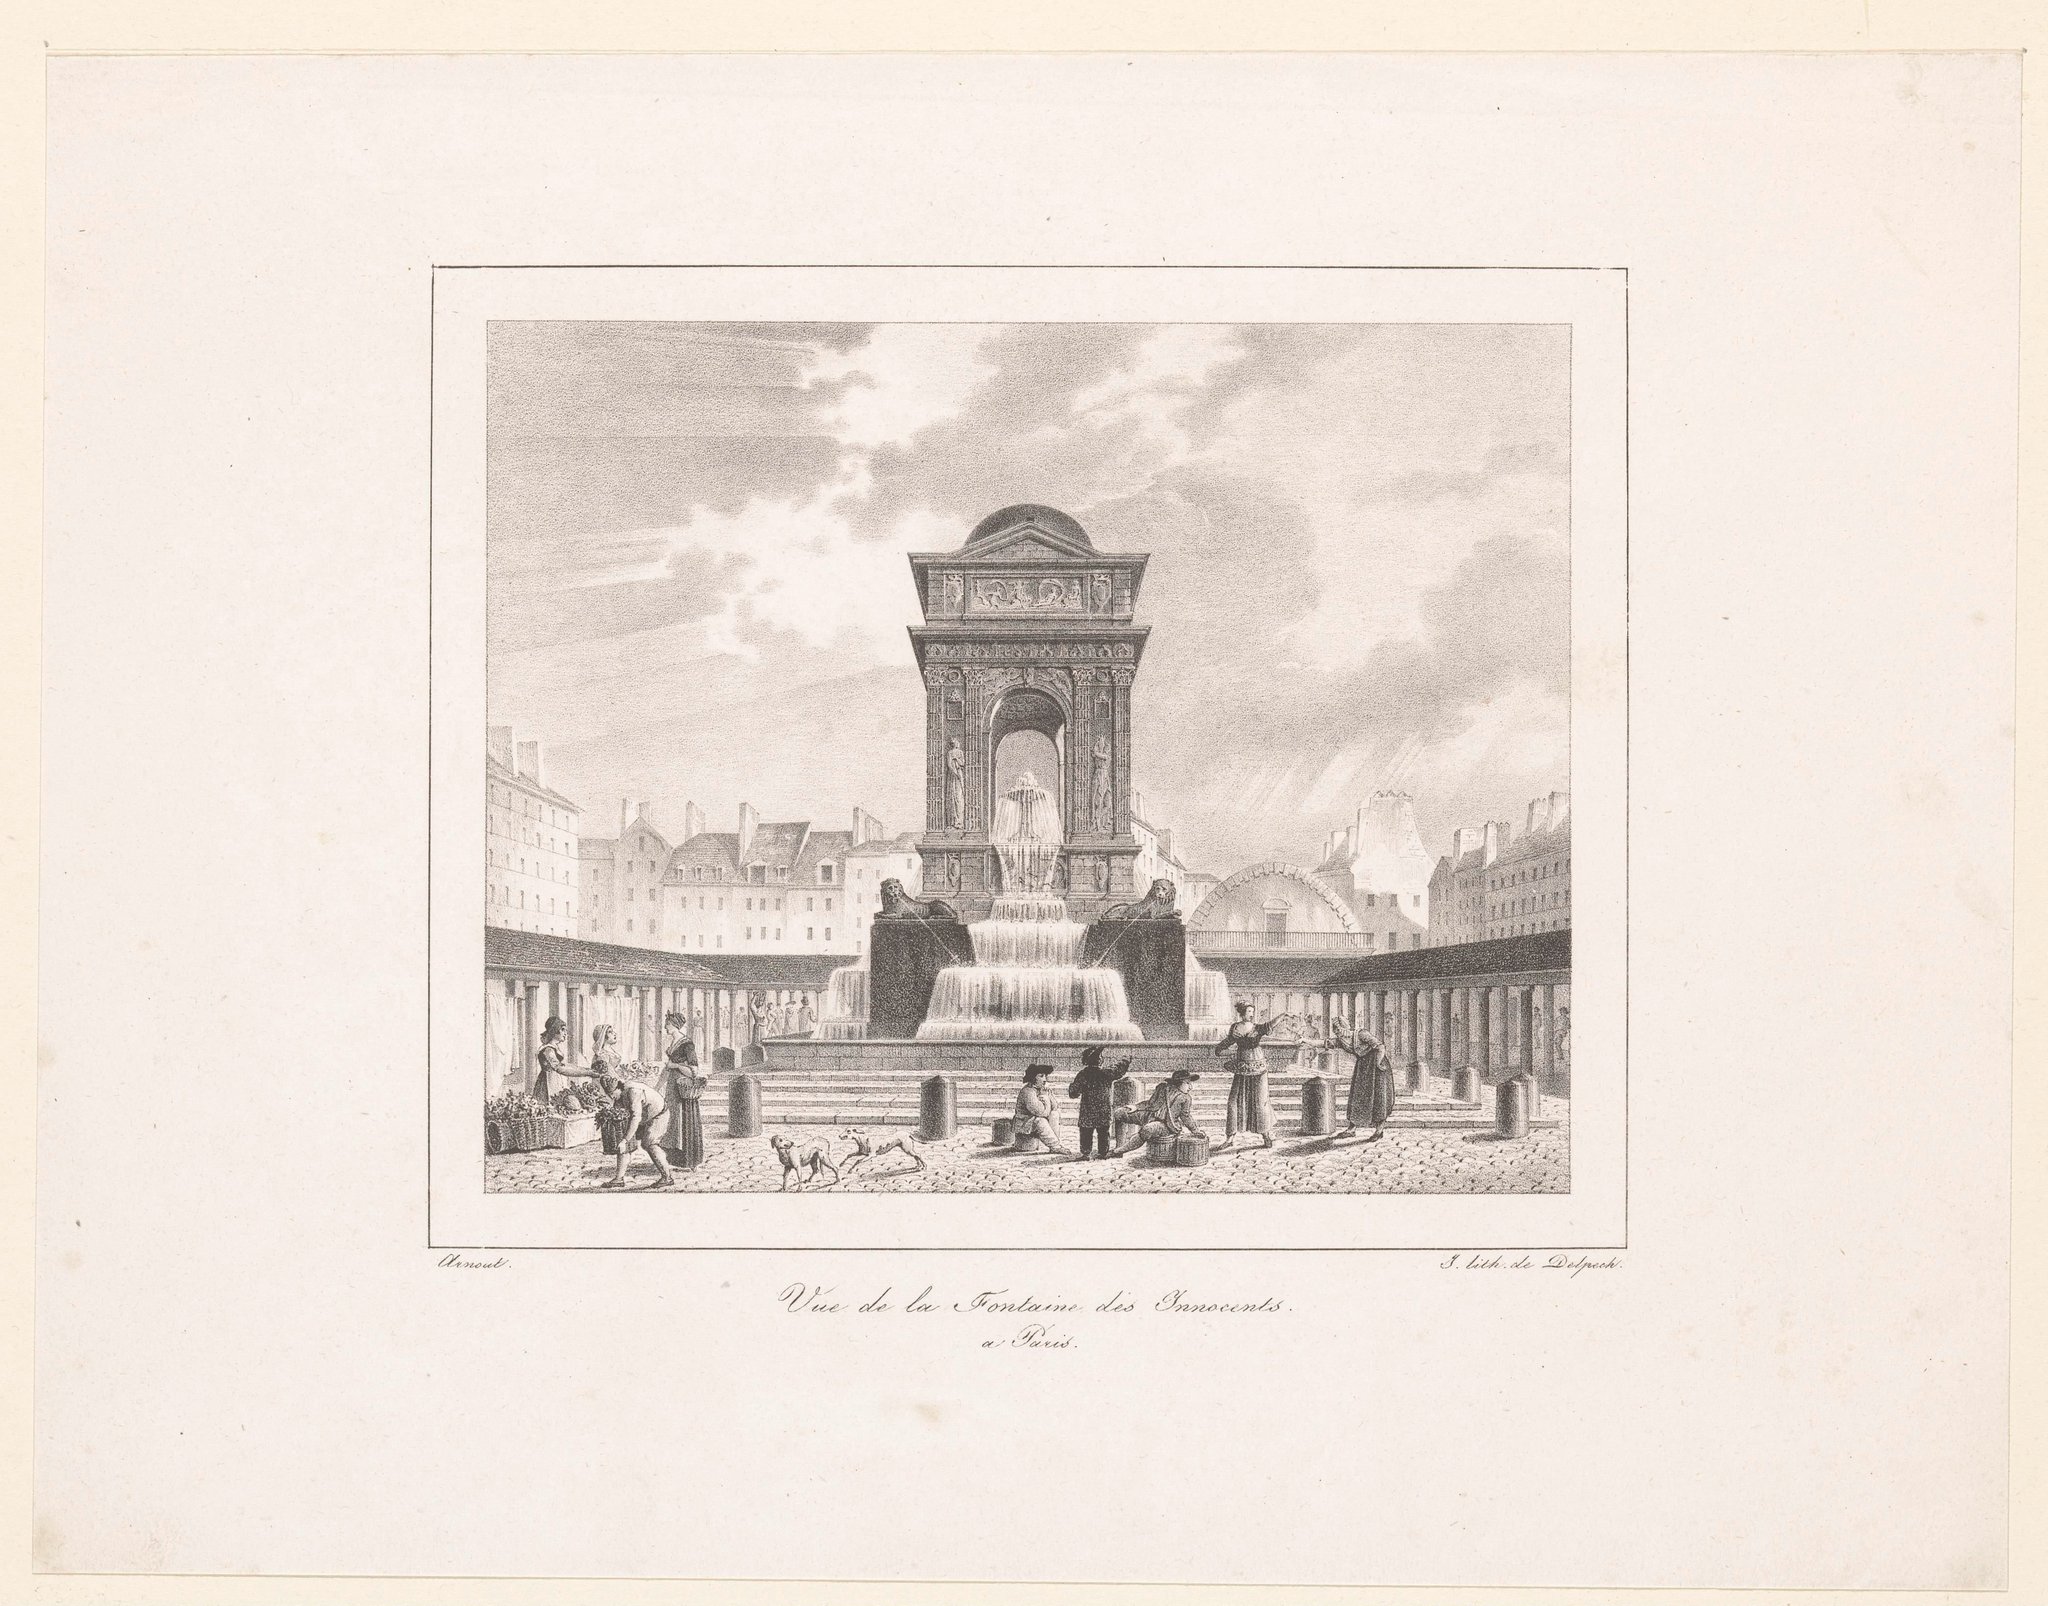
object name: print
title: Kleine gezichten van Parijs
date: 1820-1821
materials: paper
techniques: lithograph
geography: paris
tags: ornamental fountain, market, paris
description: Op de voorgrond verkopen marktlui hun waar. De fontein staat in het midden van de overdekte markthallen op de Place du Marché des Innocents.